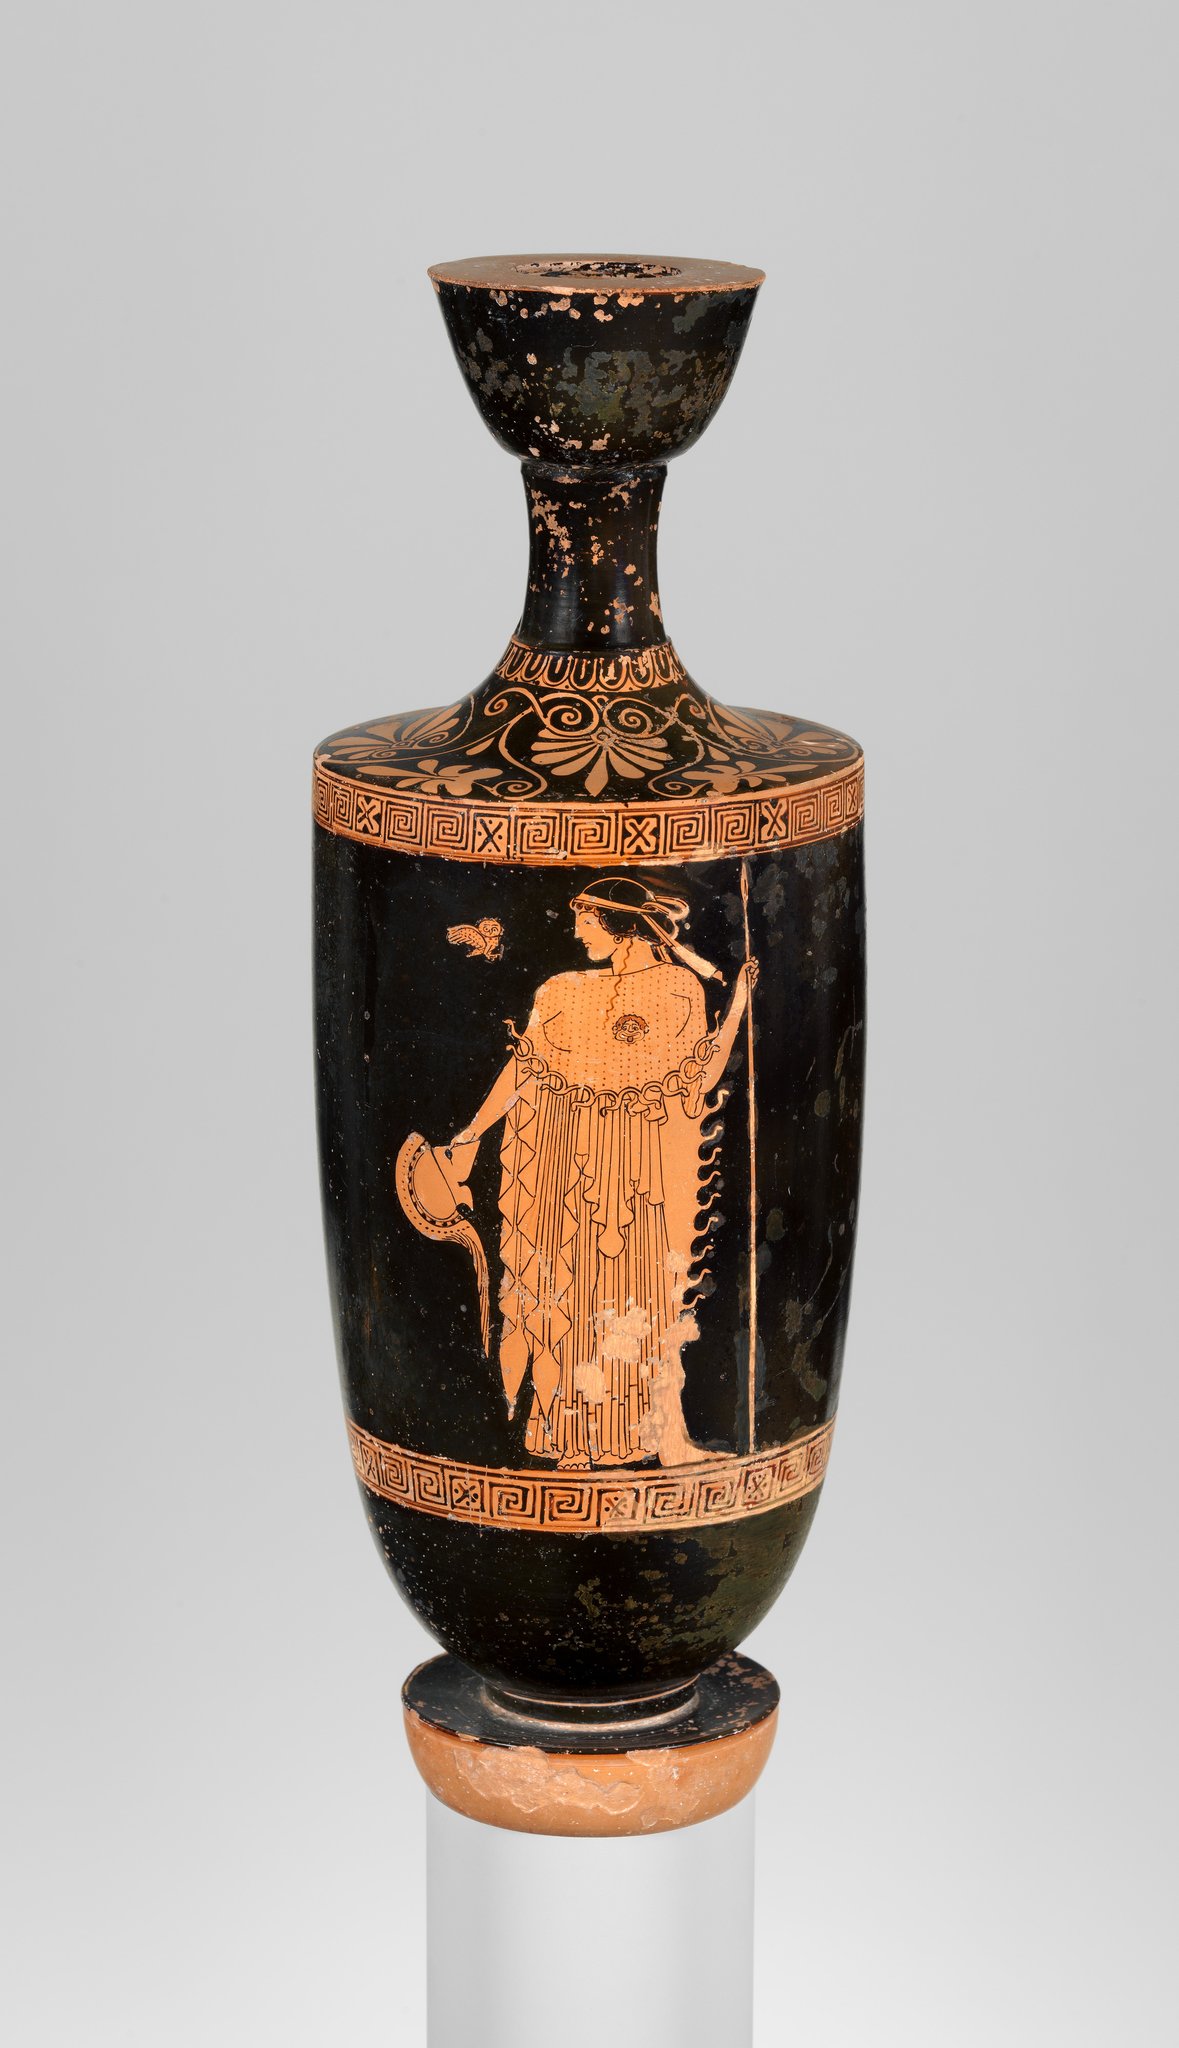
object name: lekythos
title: Terracotta lekythos (oil flask)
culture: greek, attic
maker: brygos painter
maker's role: artist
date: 490-480 BCE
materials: terracotta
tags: helmets,spears,athena,owls